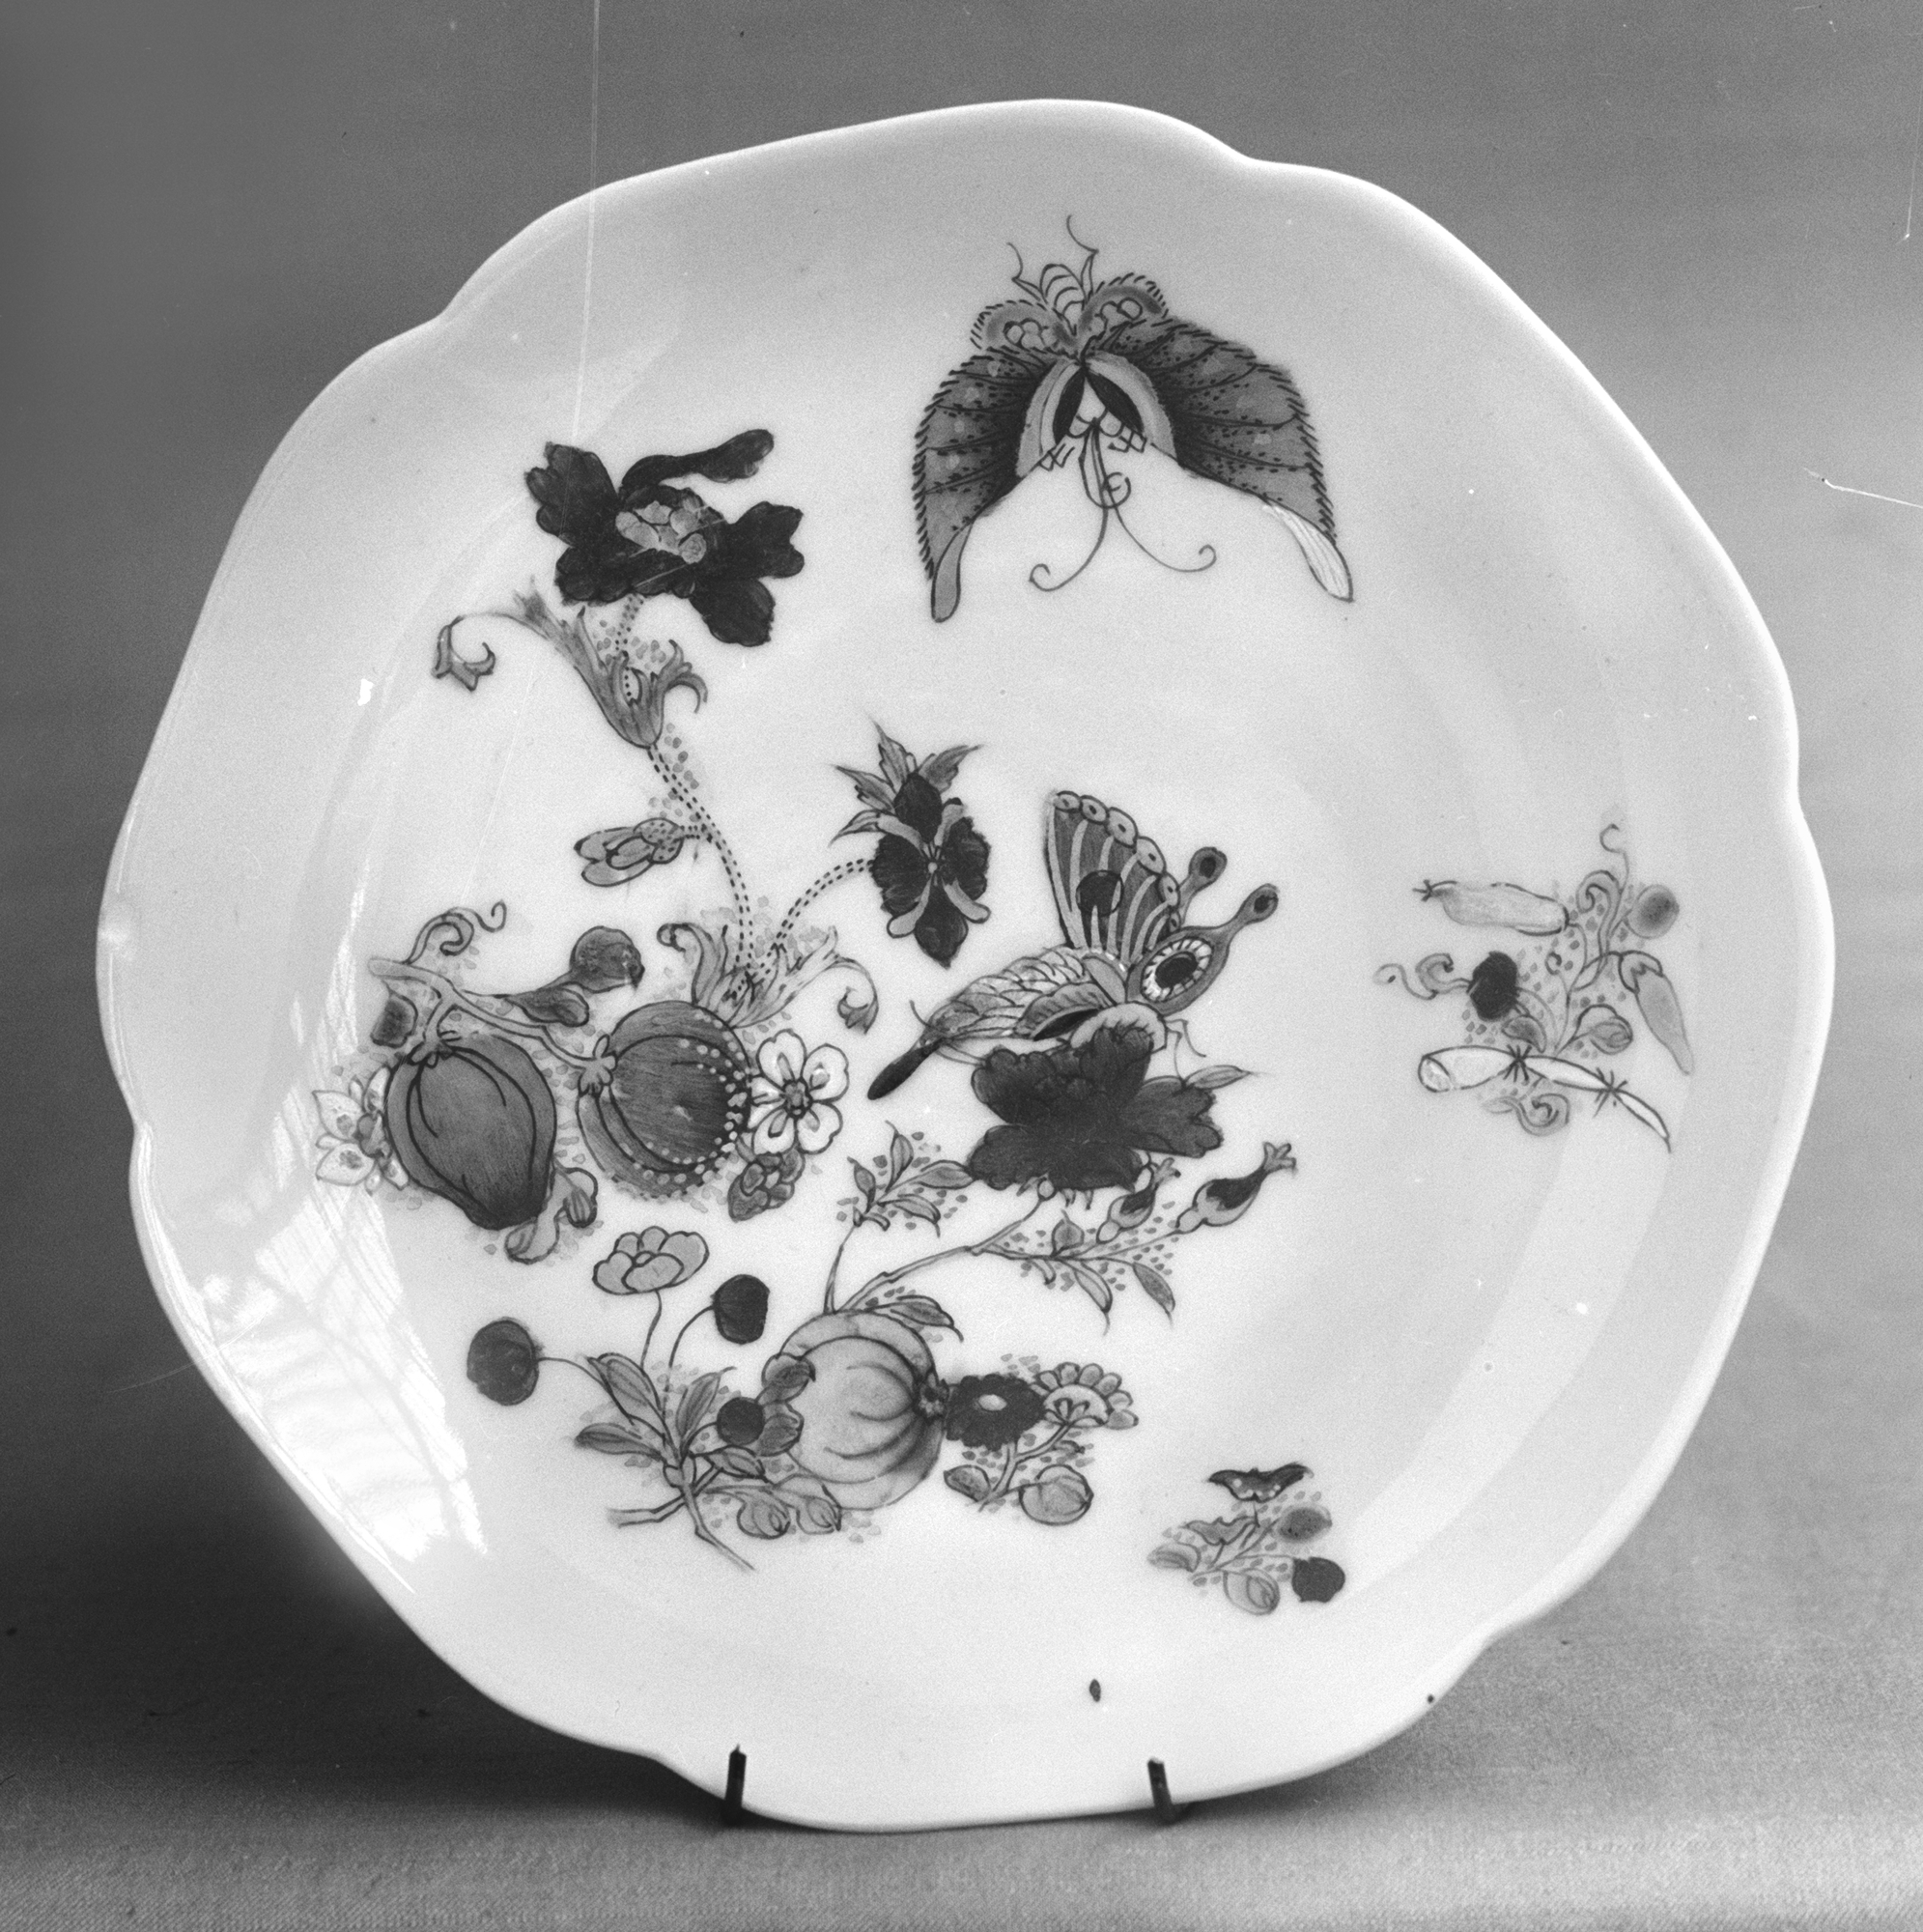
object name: saucer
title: Saucer with butterflies and melons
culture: chinese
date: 1767-1800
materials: enamel, porcelain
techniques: overglaze, painting, polychrome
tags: butterflies,flowers